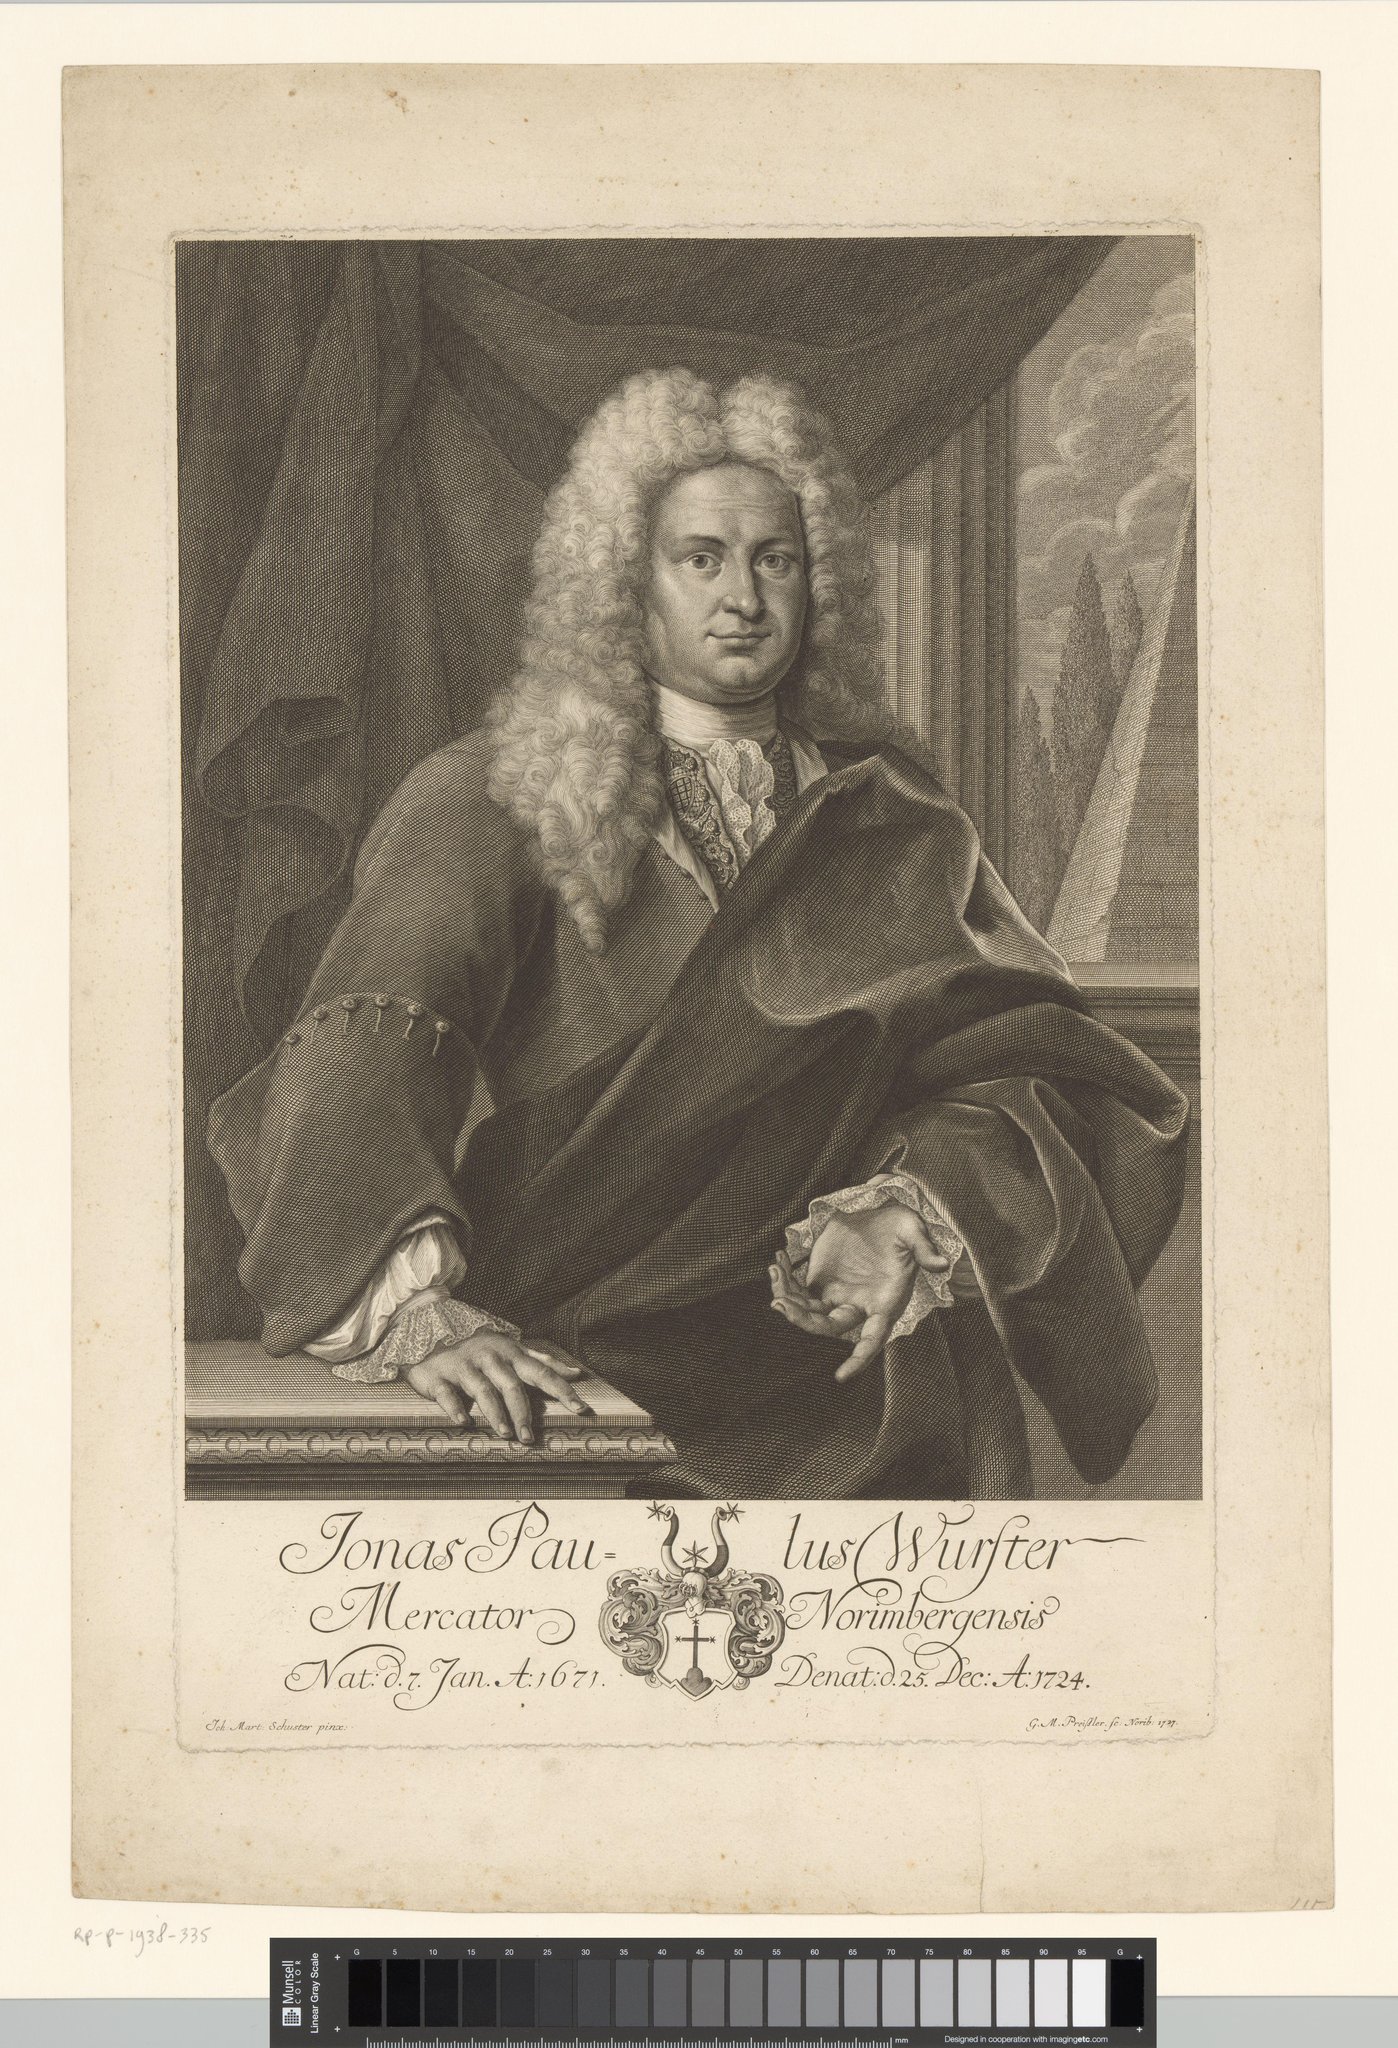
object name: print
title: Portret van Jonas Paul Wurster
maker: georg martin preissler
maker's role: print maker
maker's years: 1700-1754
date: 1727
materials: paper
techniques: engraving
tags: pyramids (garden ornaments), historical persons, armorial bearing, heraldry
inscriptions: collector's mark: Lugt 2228